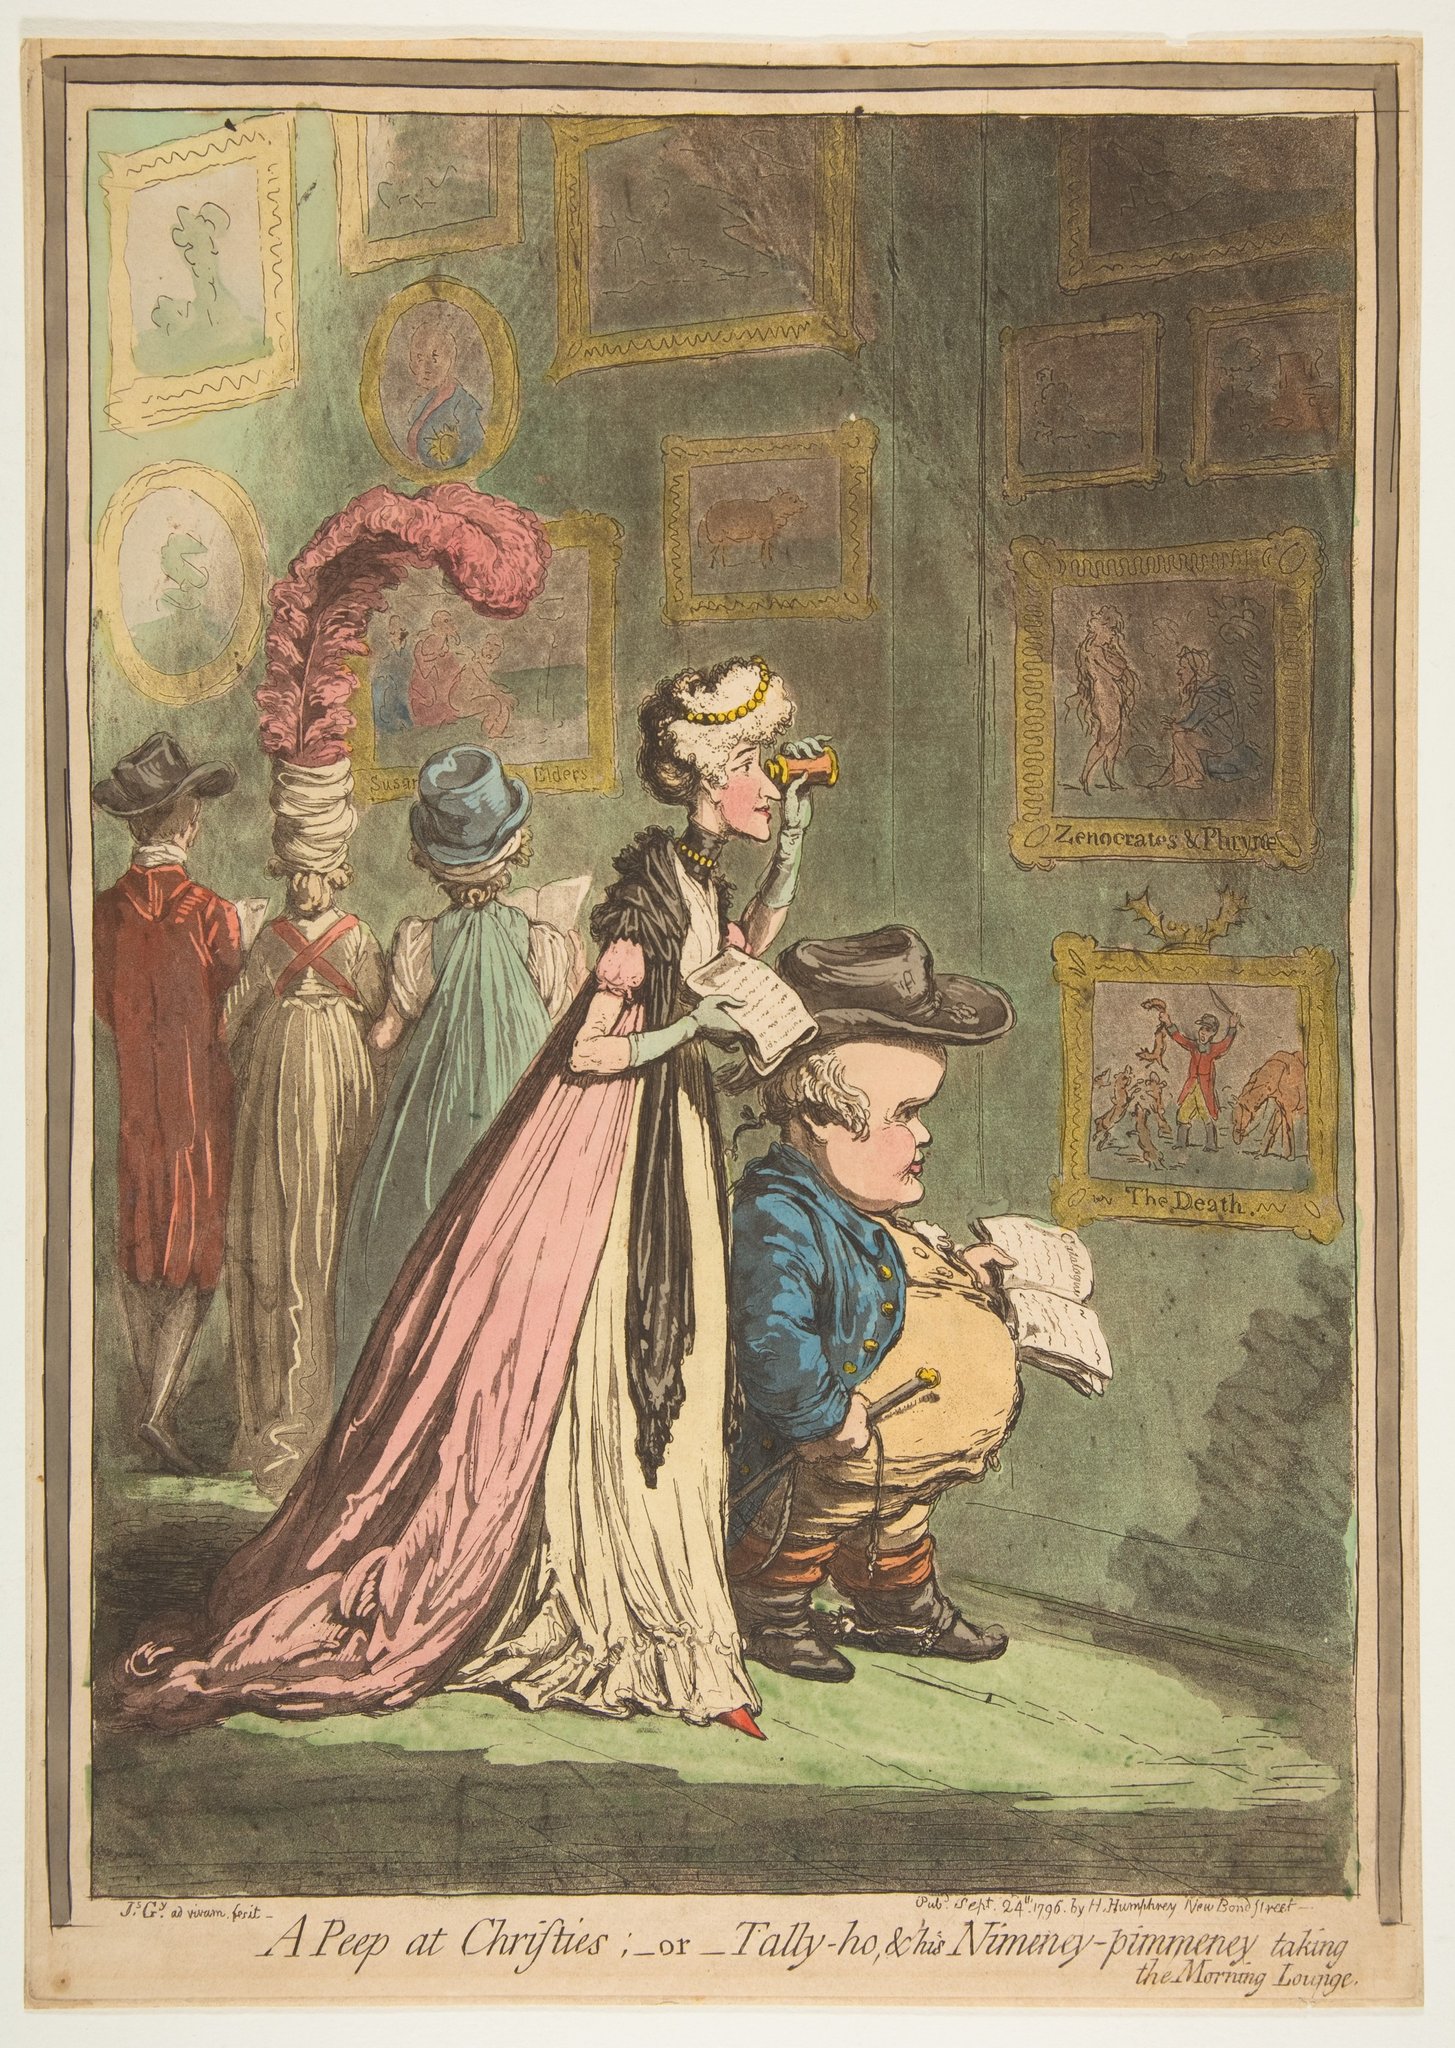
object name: print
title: A Peep at Christies;–or–Tally-ho & his Nimeny-pimeney taking the Morning Lounge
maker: james gillray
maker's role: artist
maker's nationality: british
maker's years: 1756-1815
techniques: aquatint, etching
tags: men,women